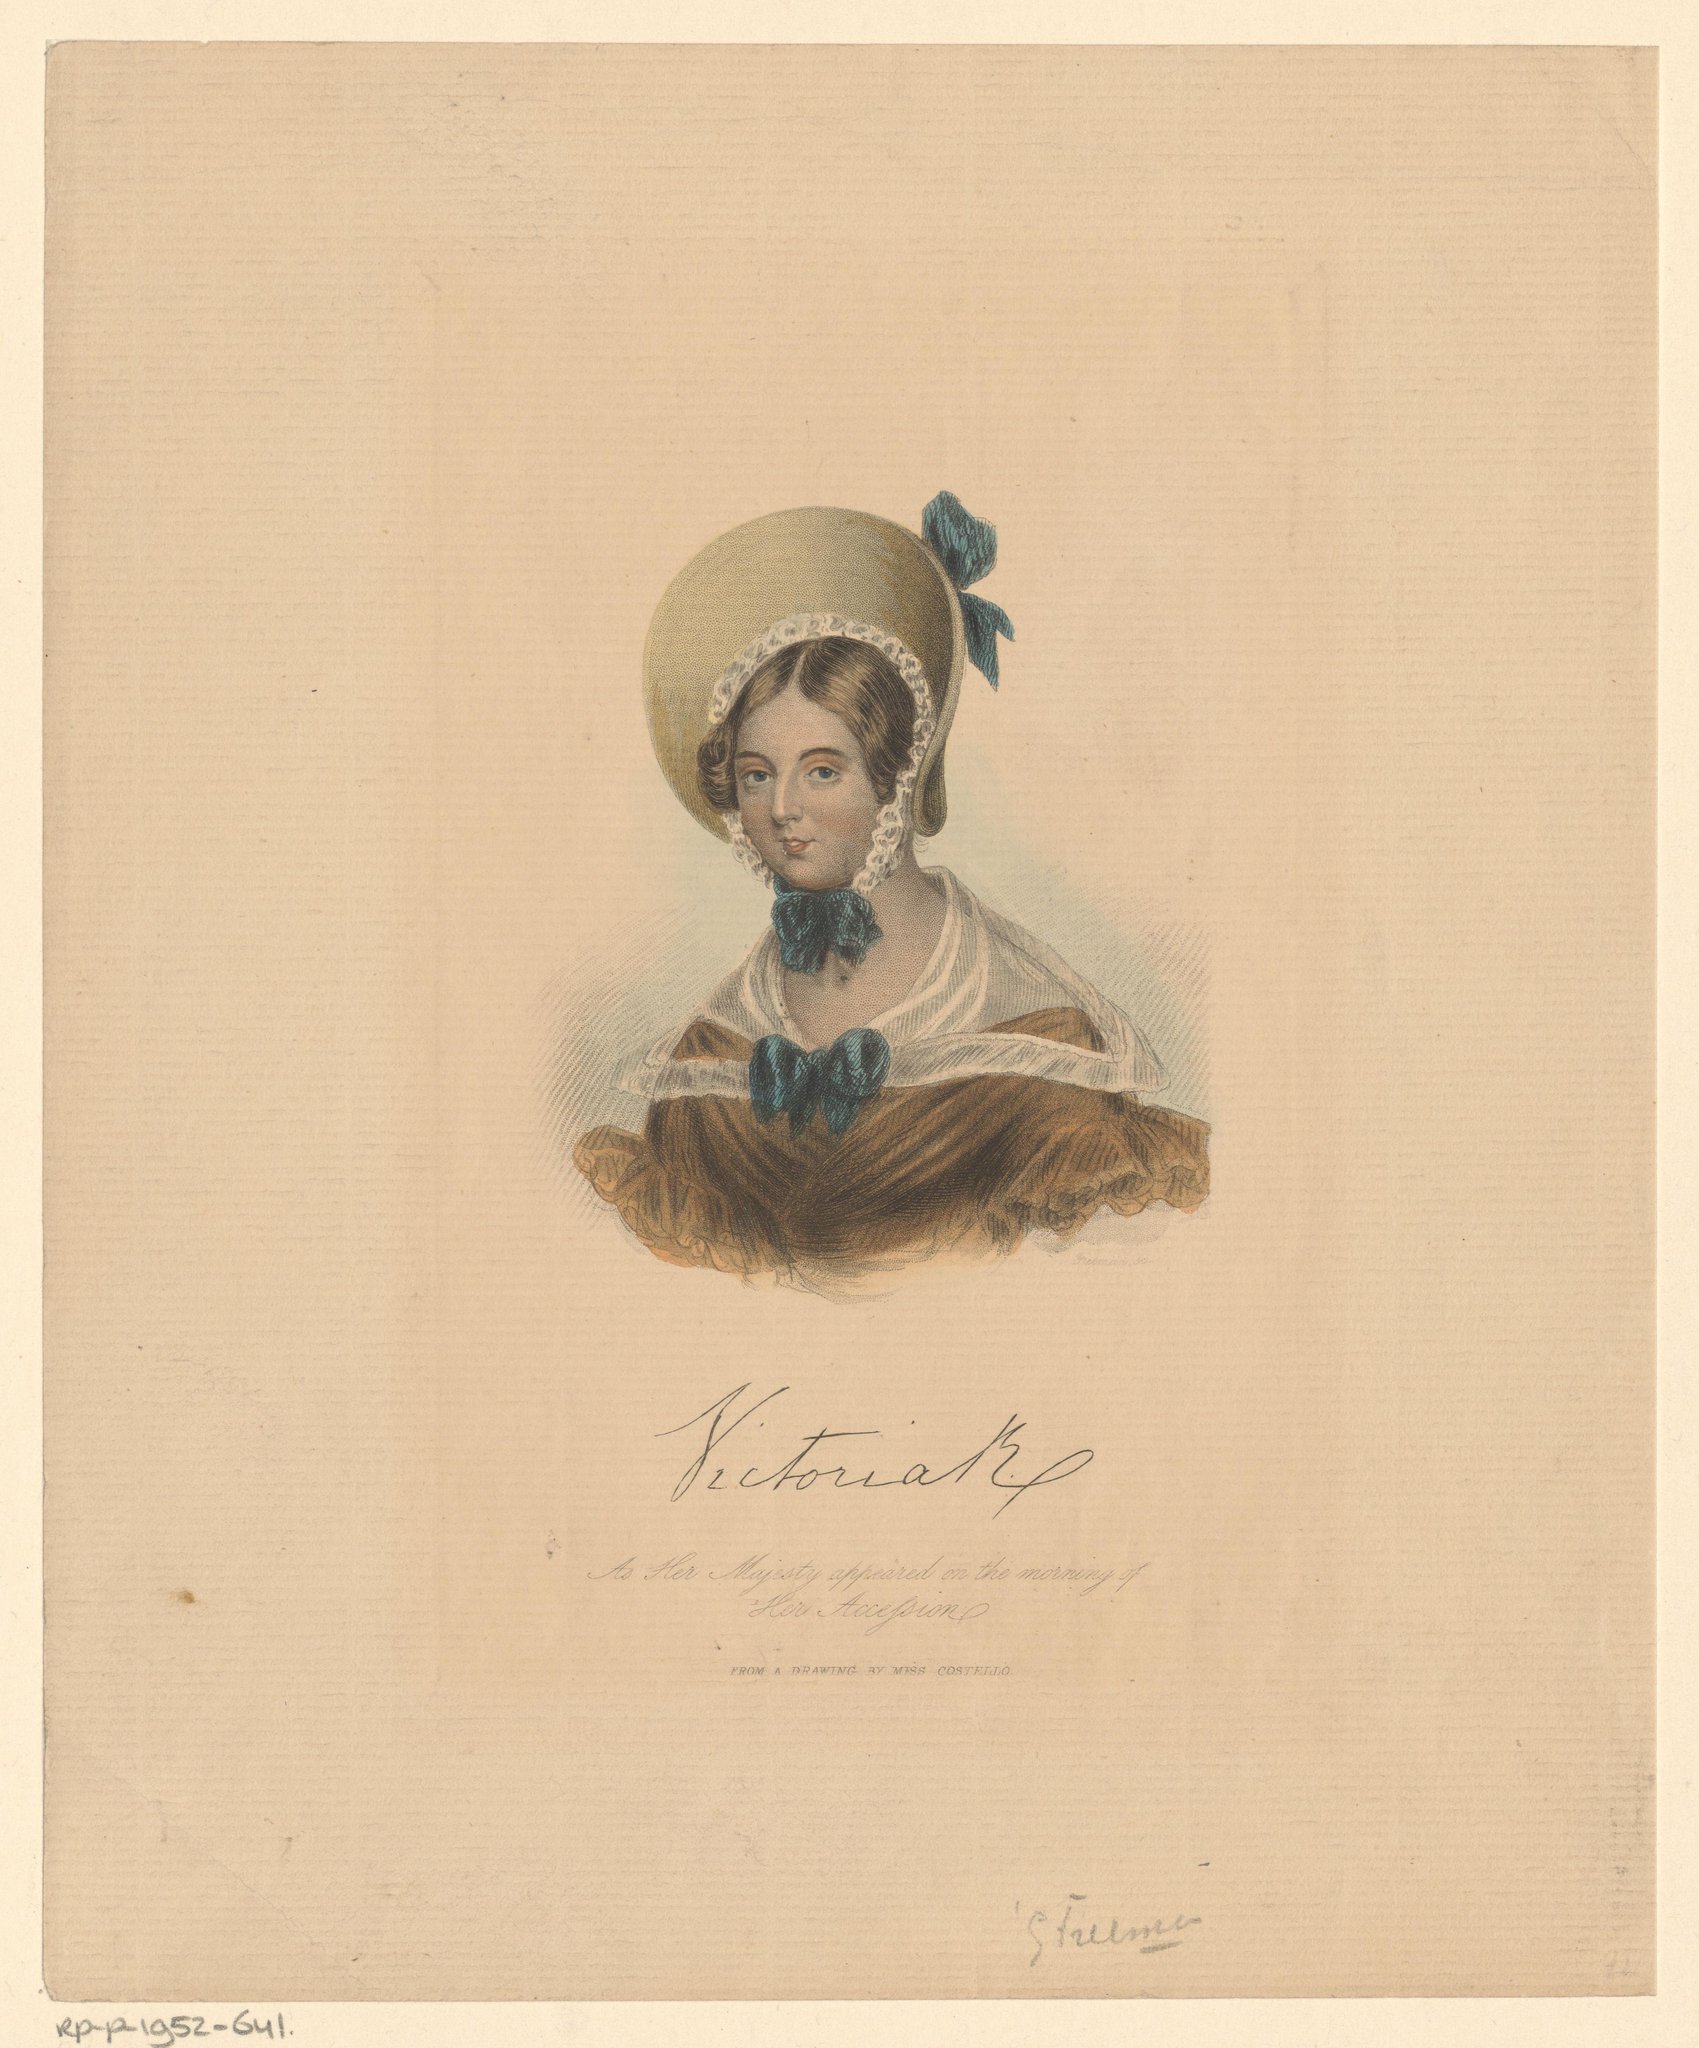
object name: print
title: Portret van koningin Victoria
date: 1837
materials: paper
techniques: etching, hand coloring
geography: united kingdom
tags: victoria (koningin van het verenigd koninkrijk en keizerin van india), historical persons - bb - woman, crown princess - bb - female ruler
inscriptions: collector's mark: Lugt 2760, collector's mark: Lugt 2228